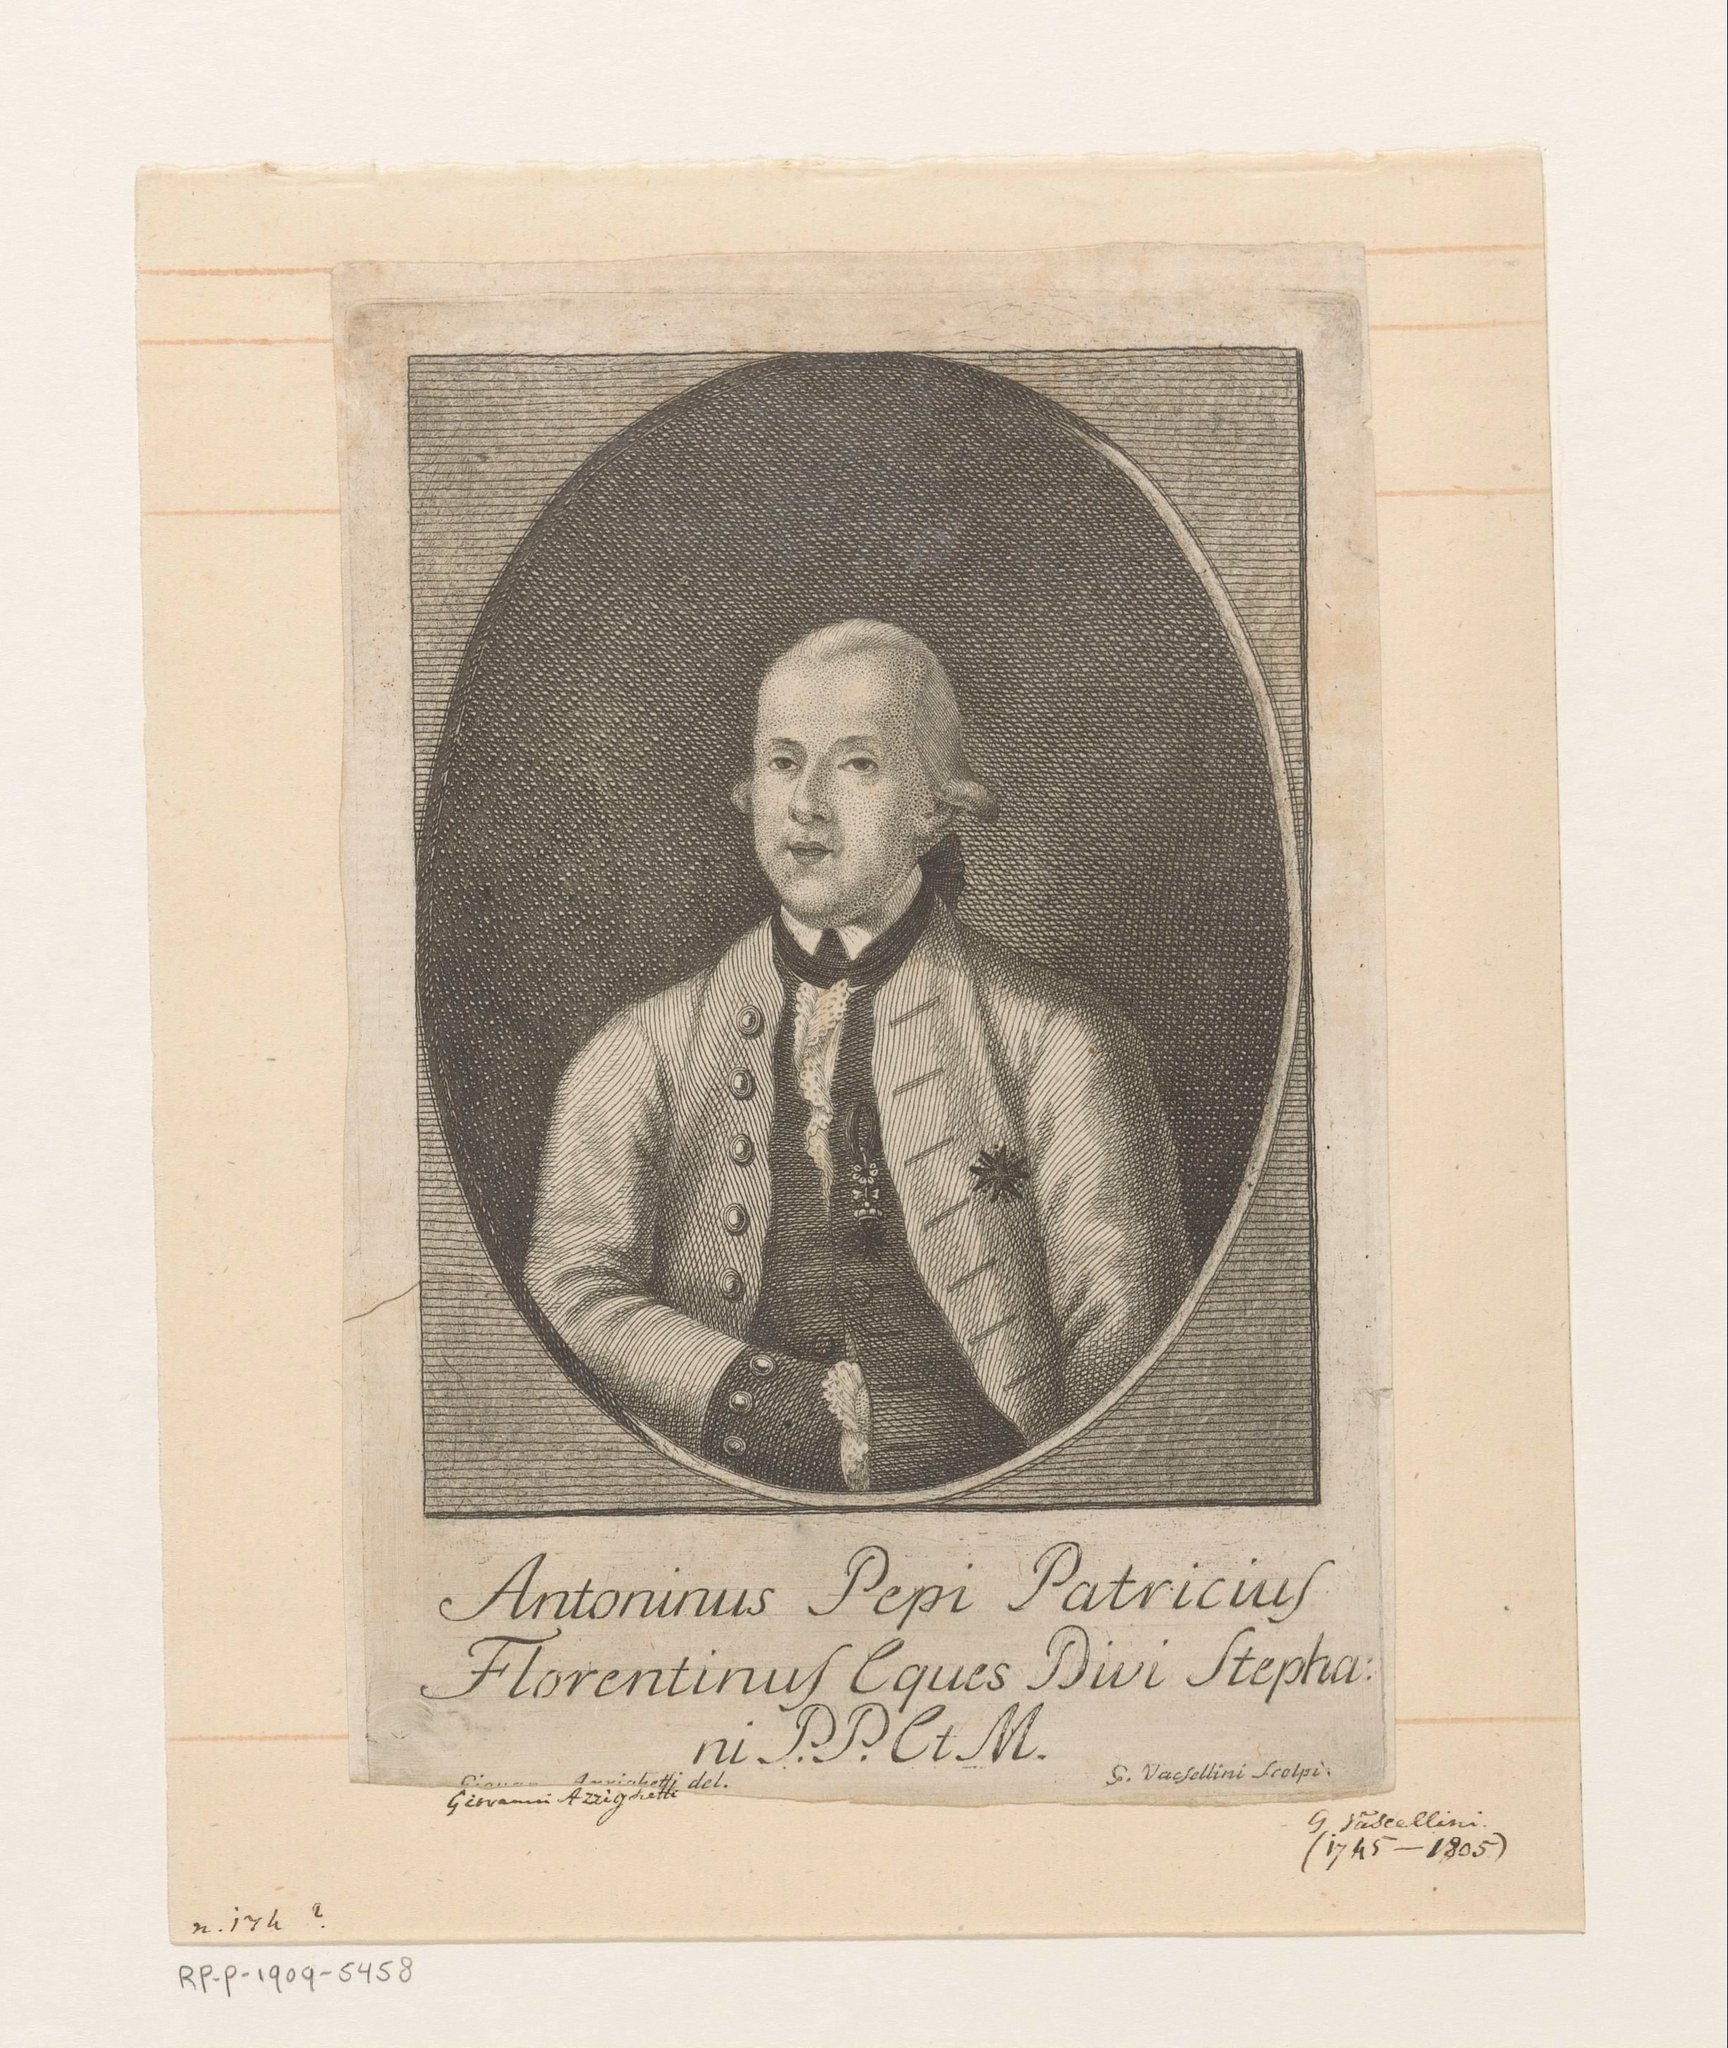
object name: print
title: Portret van Antoninus Pepi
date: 1755-1805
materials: paper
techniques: engraving, etching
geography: italy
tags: historical persons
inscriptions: collector's mark: Lugt 2228, number: ‘831.’